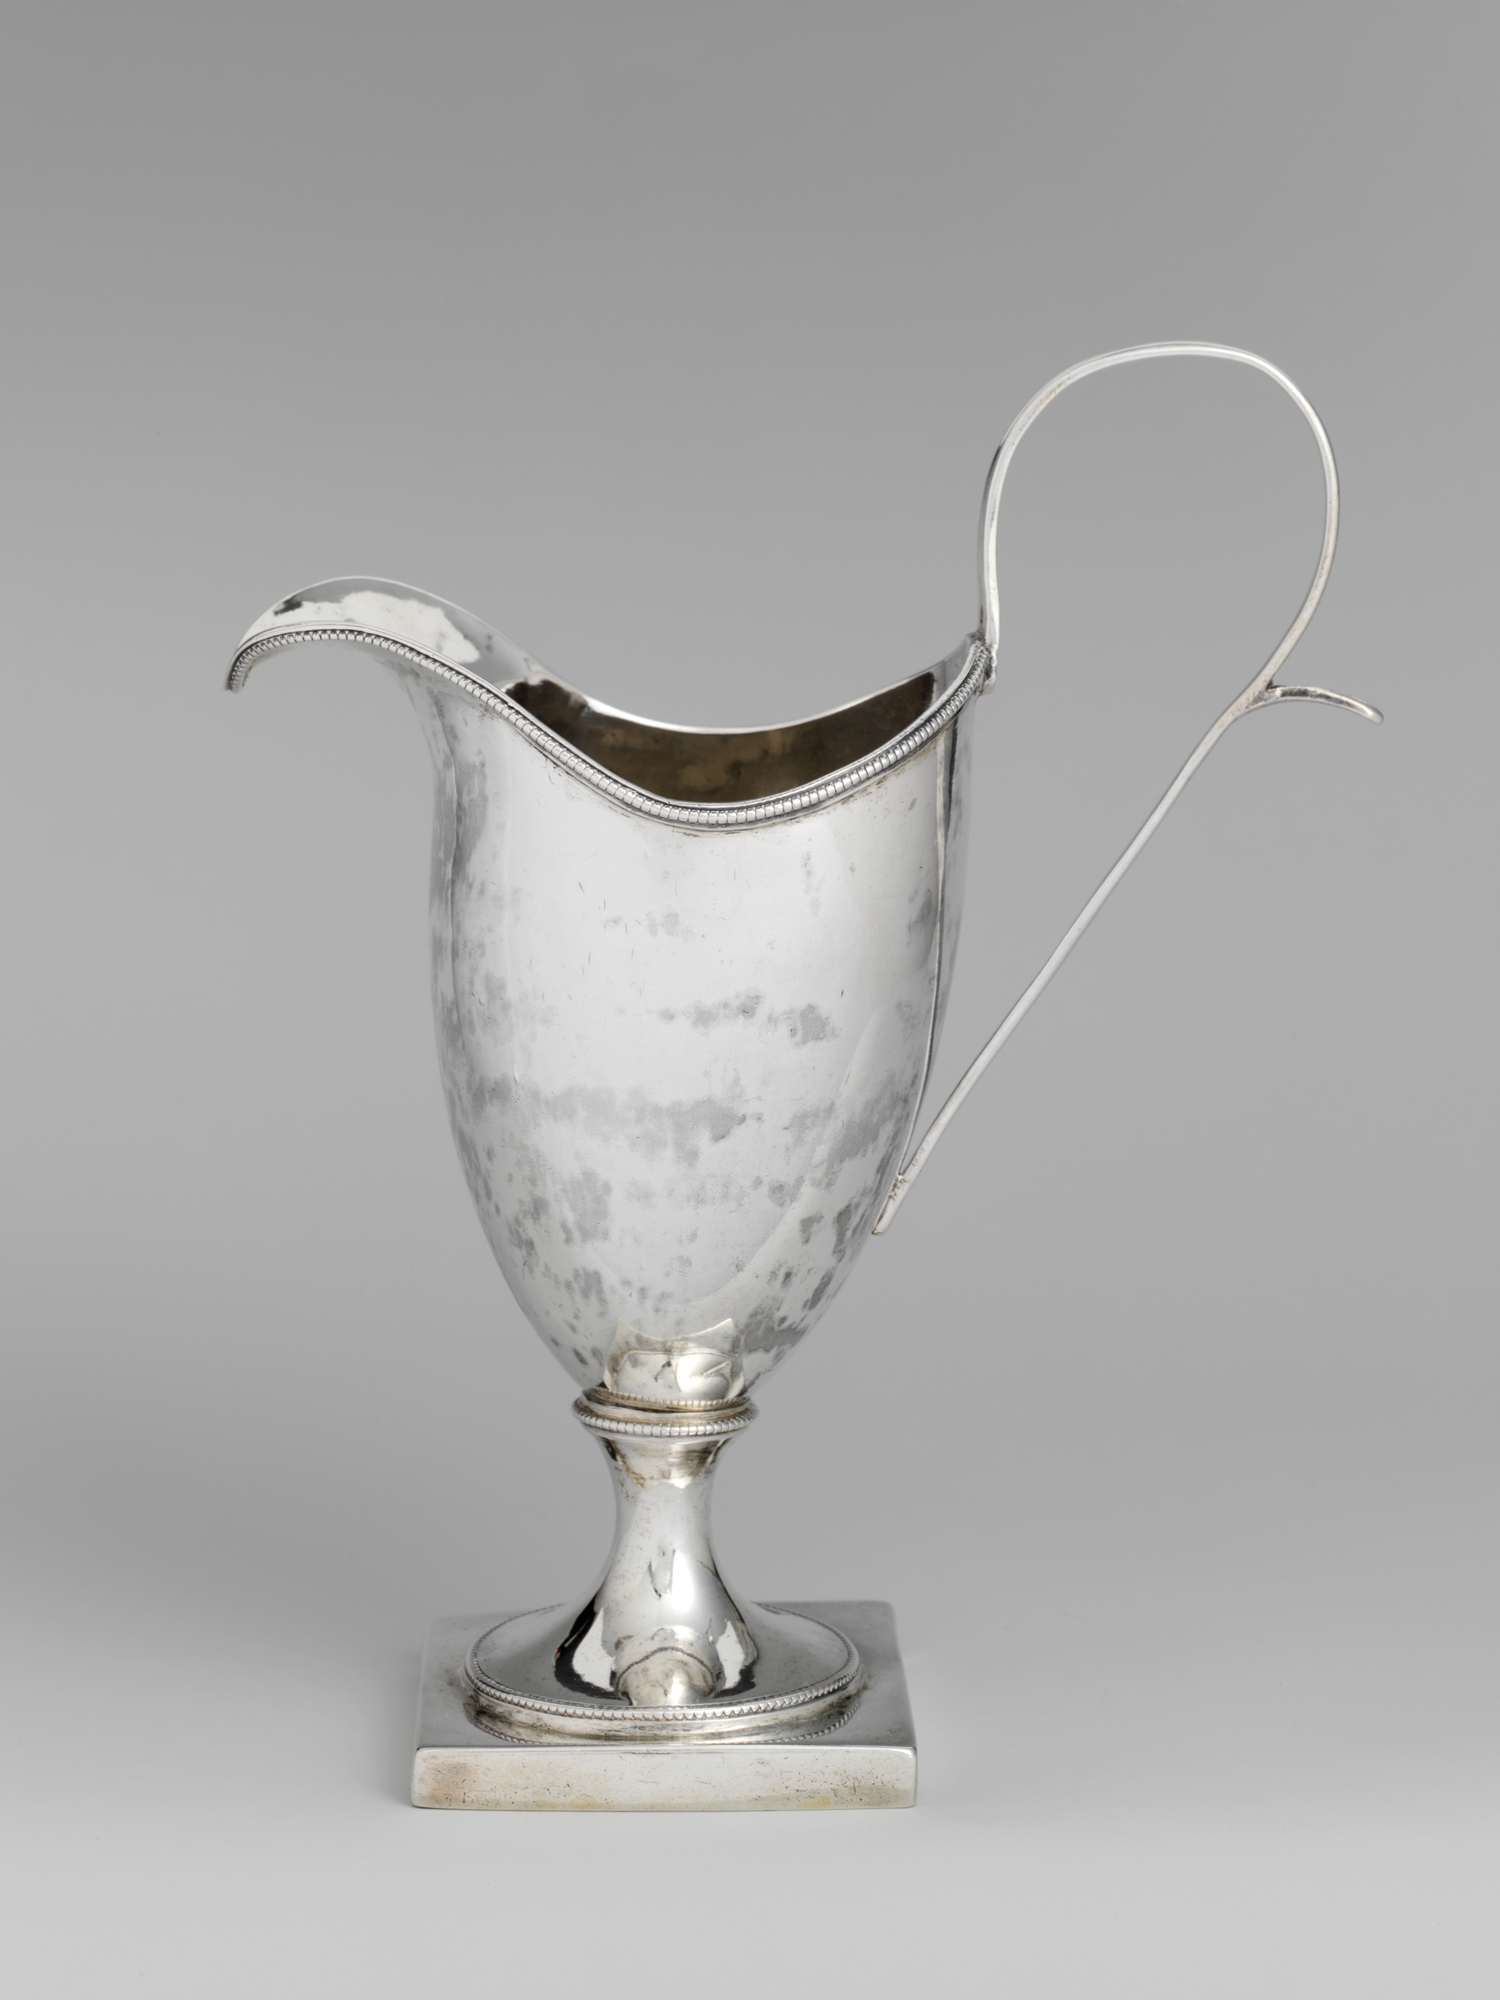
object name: cream pot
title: Creamer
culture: american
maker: john david jr.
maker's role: maker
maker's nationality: american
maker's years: 1772-1809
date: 1790-1800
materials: silver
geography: united states